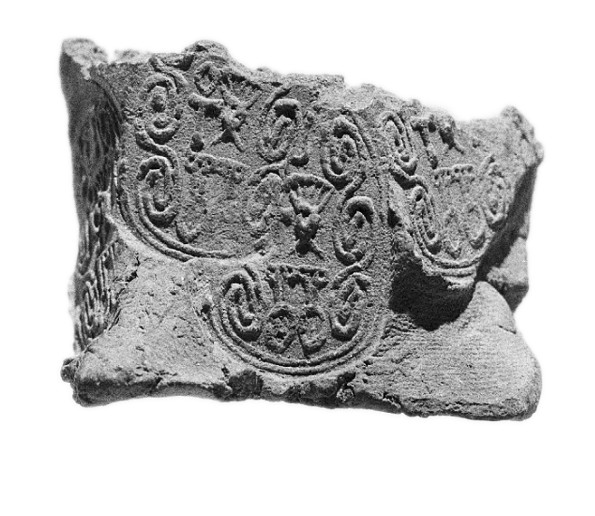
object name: sealing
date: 1981-1640 BCE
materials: clay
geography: egypt